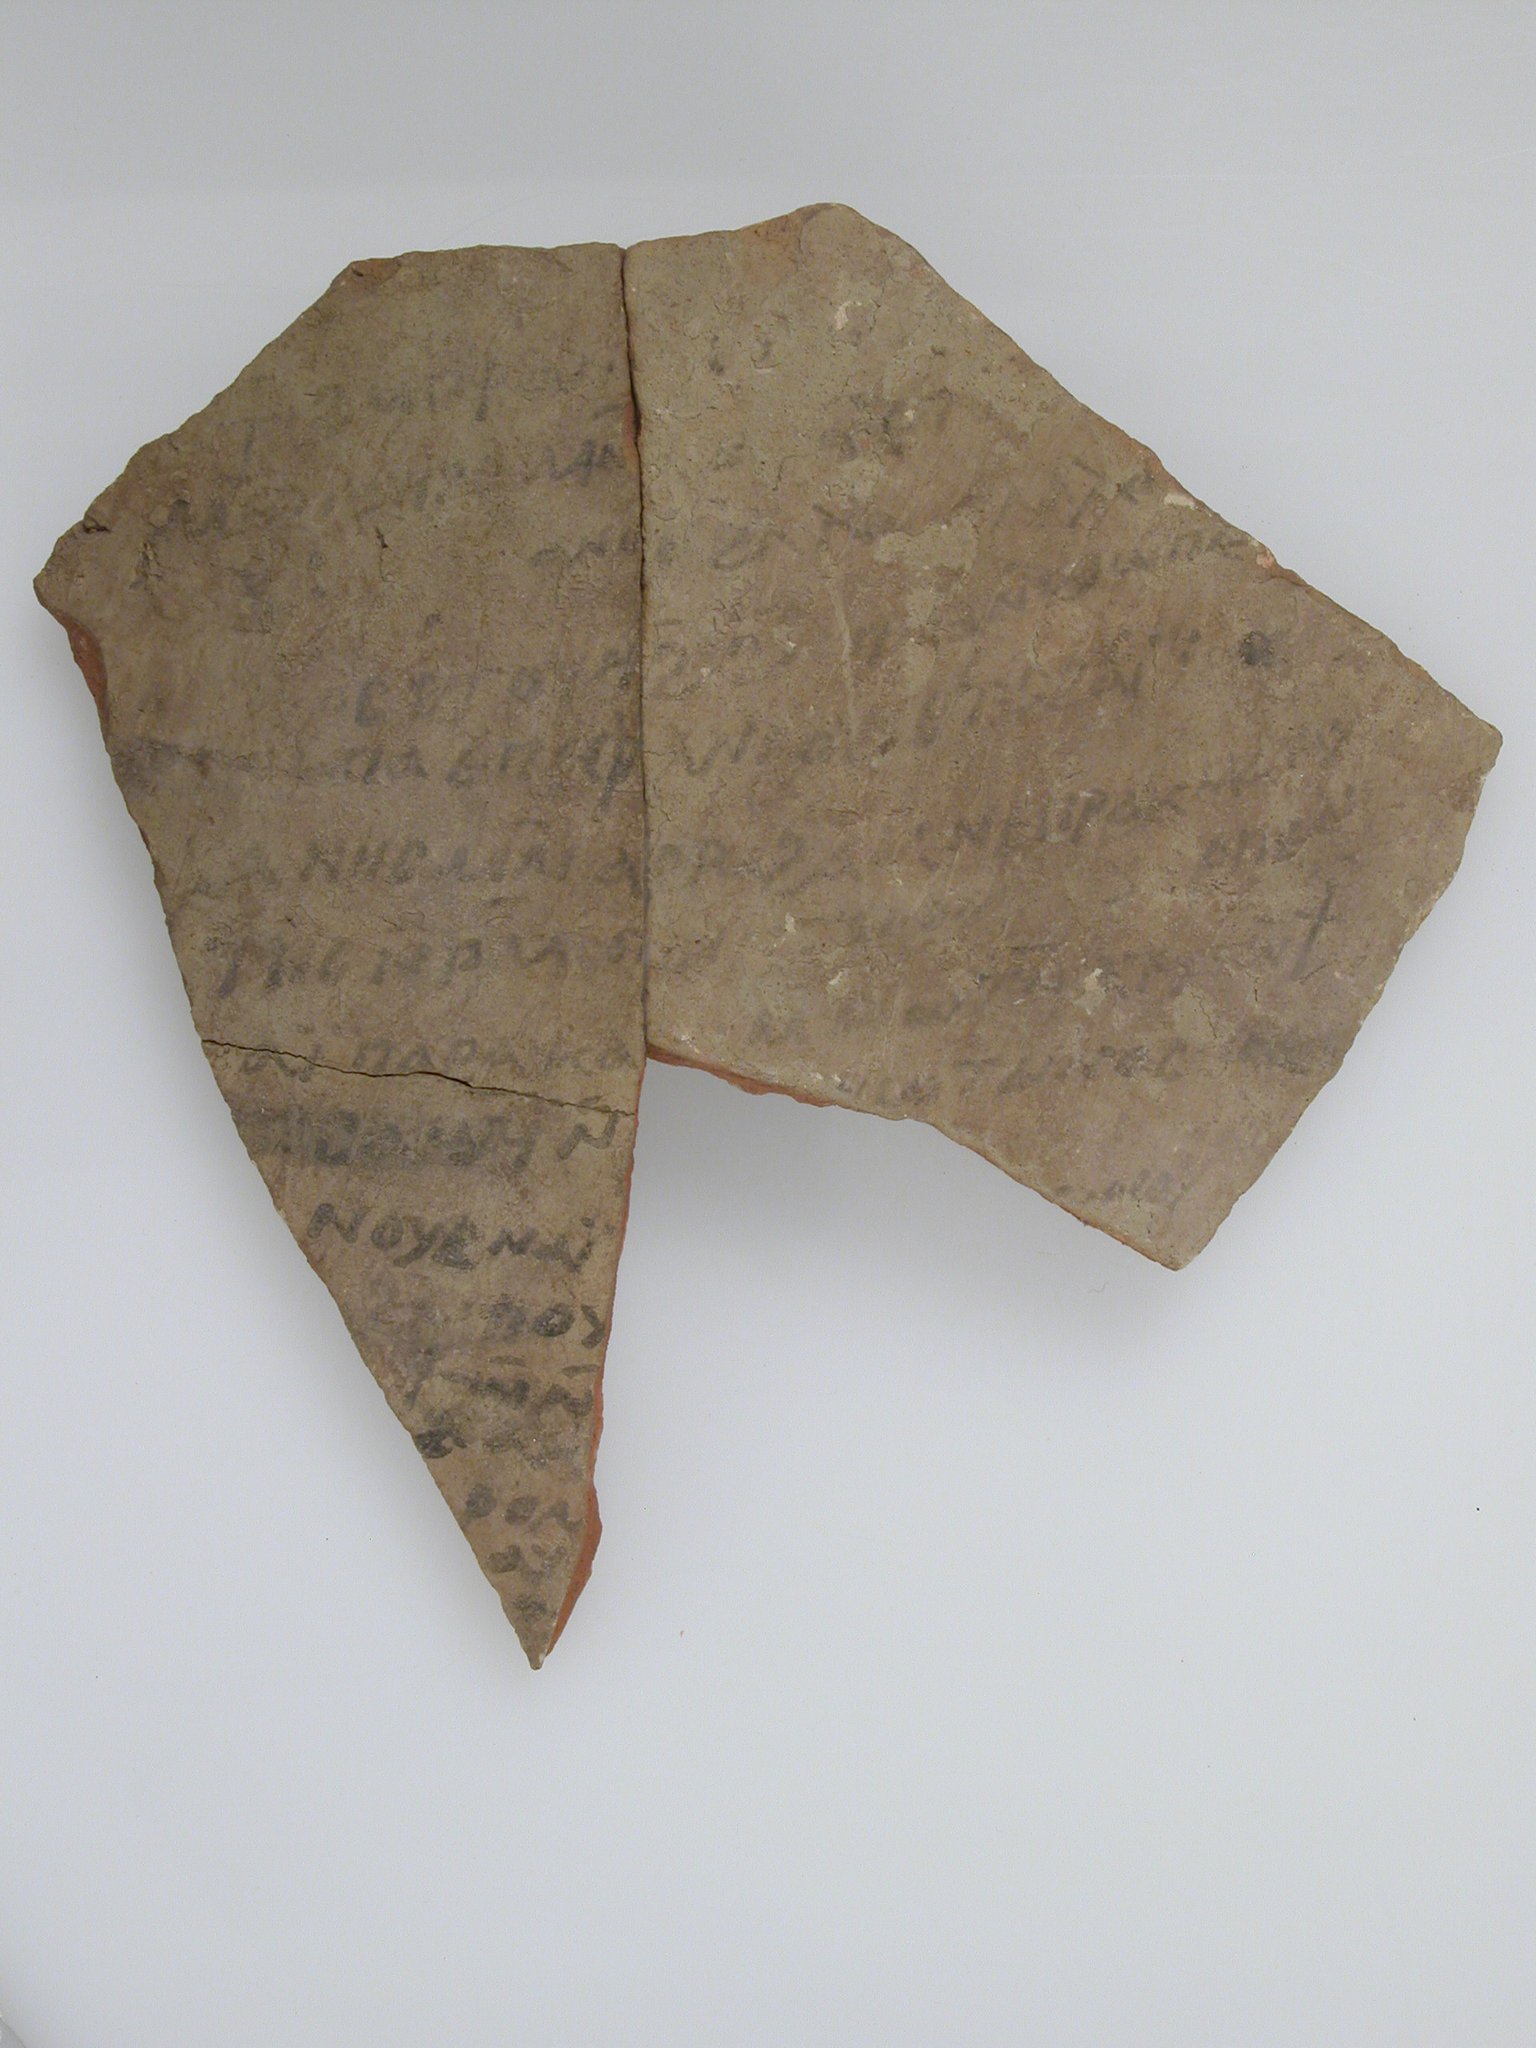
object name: ostrakon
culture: coptic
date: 601-700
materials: ink, pottery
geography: egypt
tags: documents